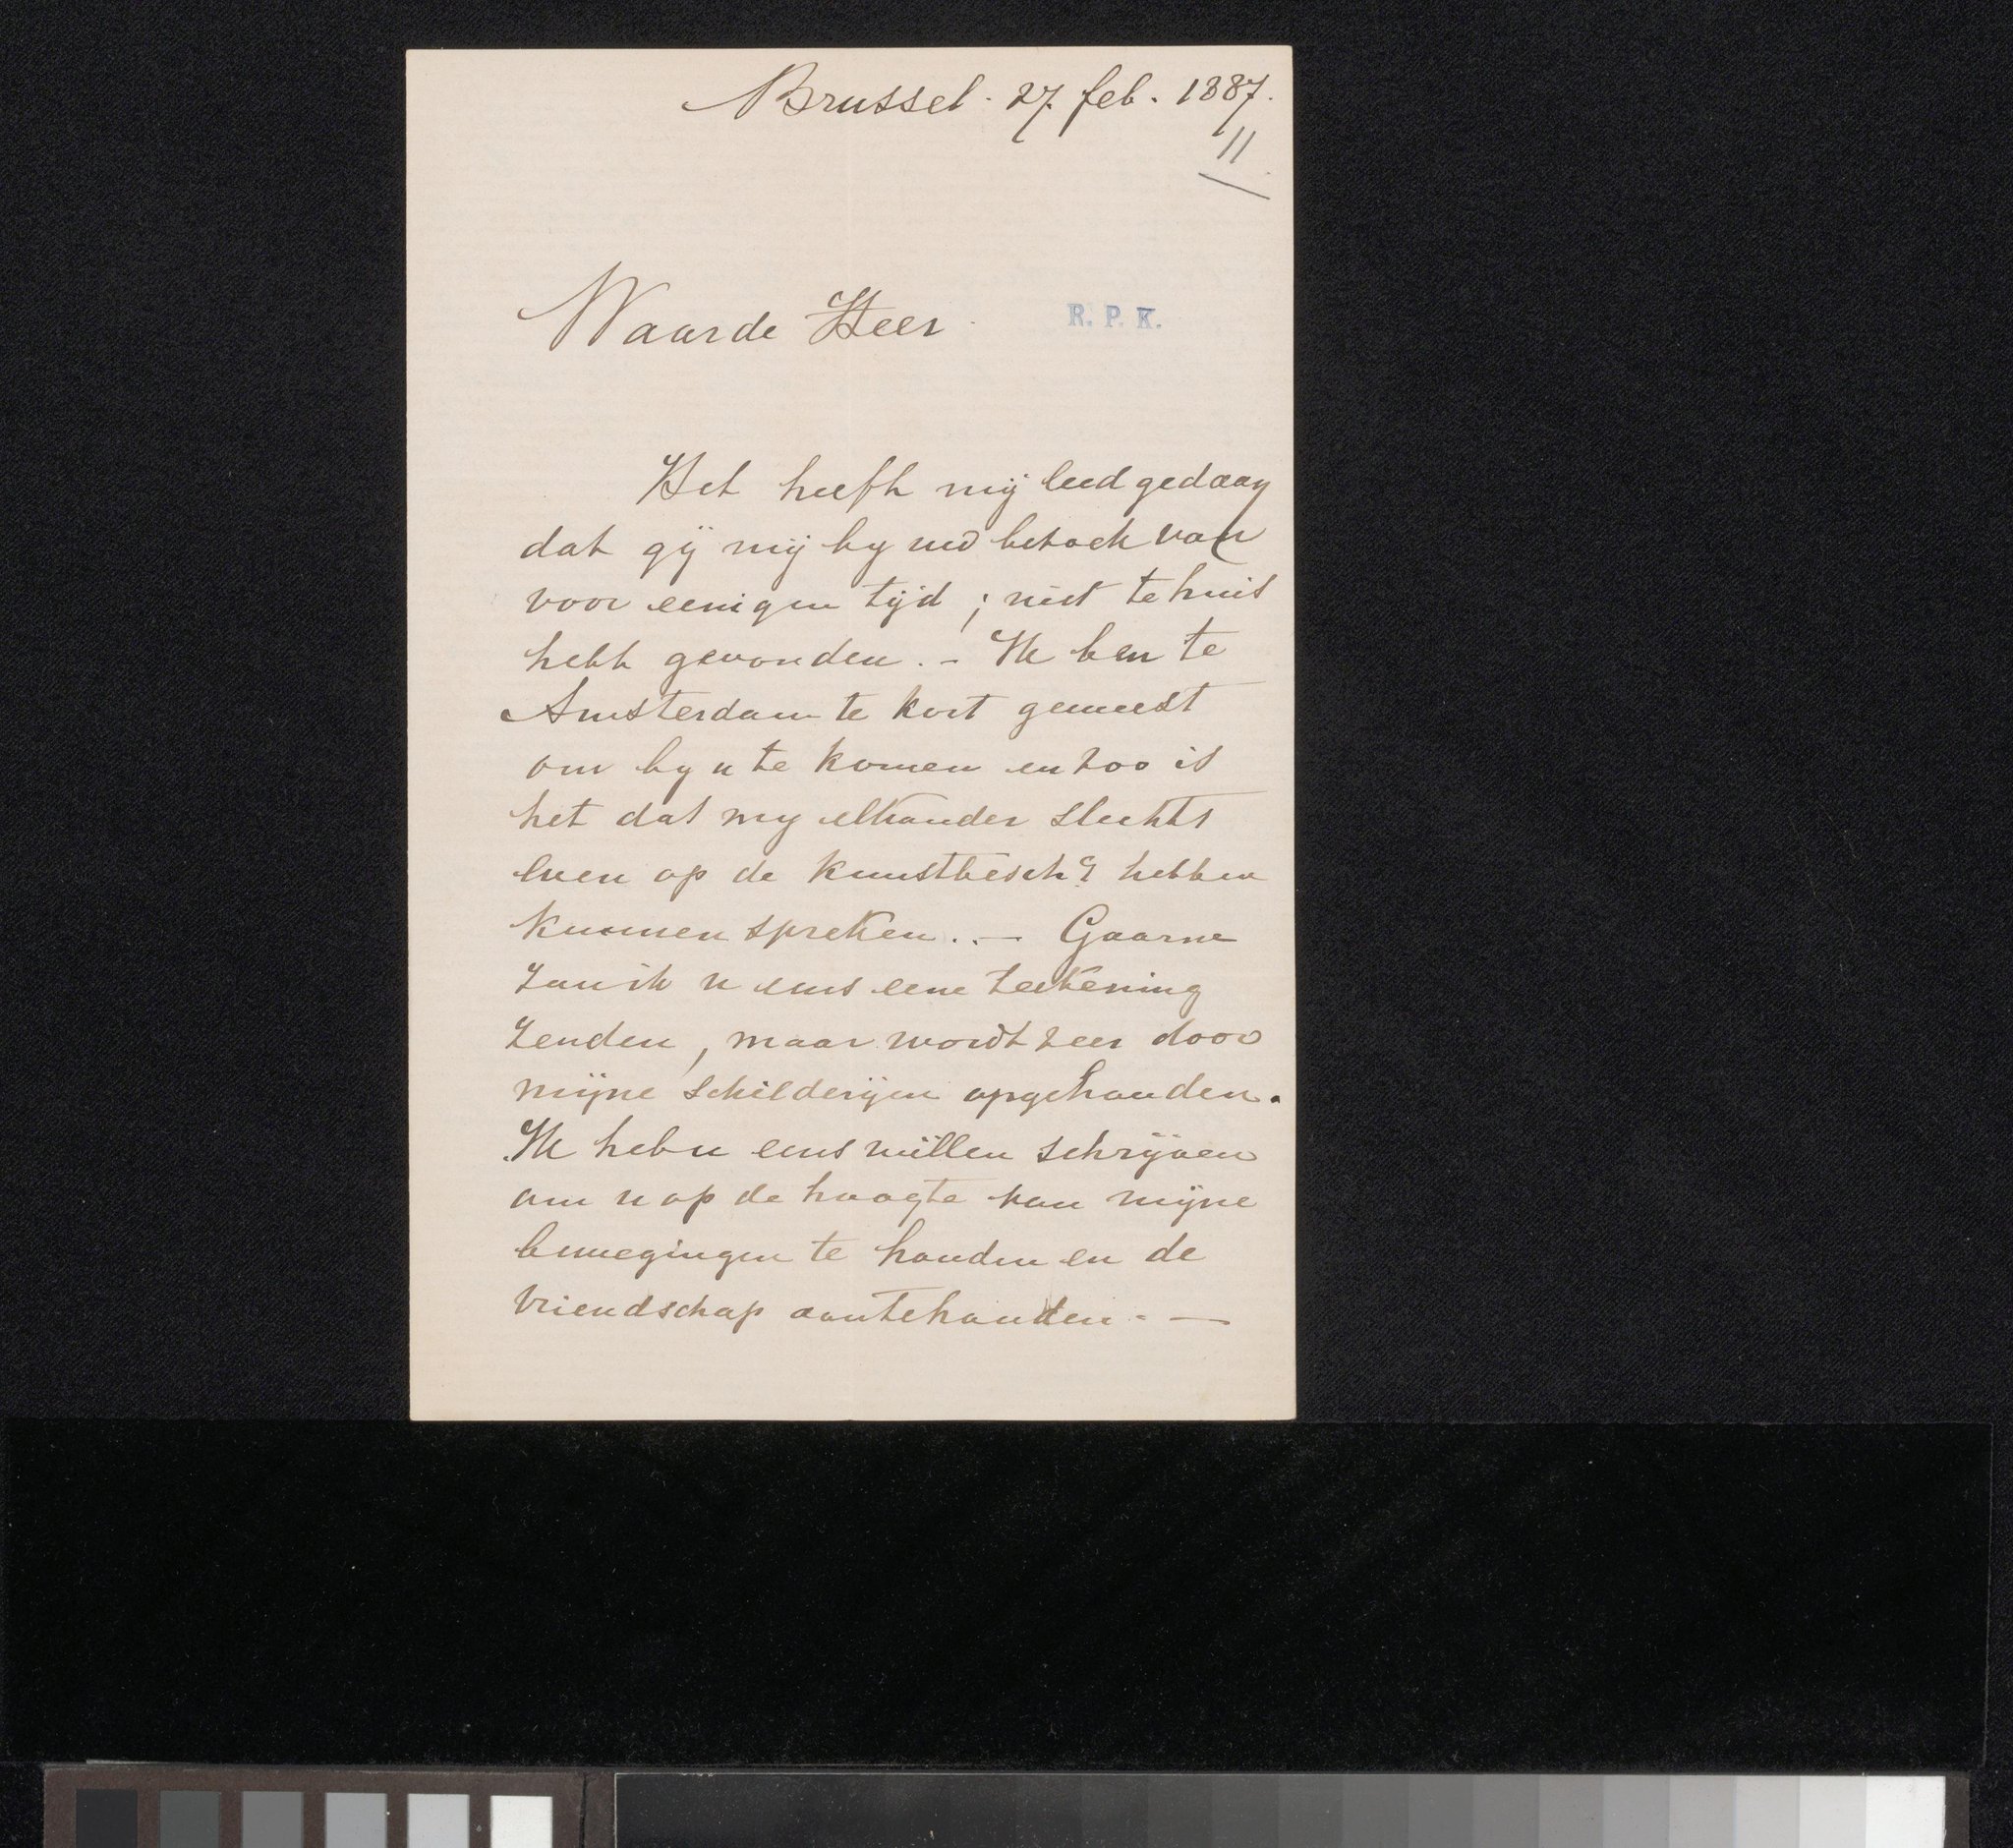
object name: letter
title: Brief aan Frans Buffa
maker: willem roelofs (i)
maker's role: draughtsman, painter, print maker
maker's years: 1822-1897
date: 1887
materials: ink, paper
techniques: pen, writing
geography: brussels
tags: utrecht, alberto caramelli, frans buffa, drawing, family life, painting (including book-illumination, miniature-painting), amsterdam, holland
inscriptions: collector's mark: Lugt 2233